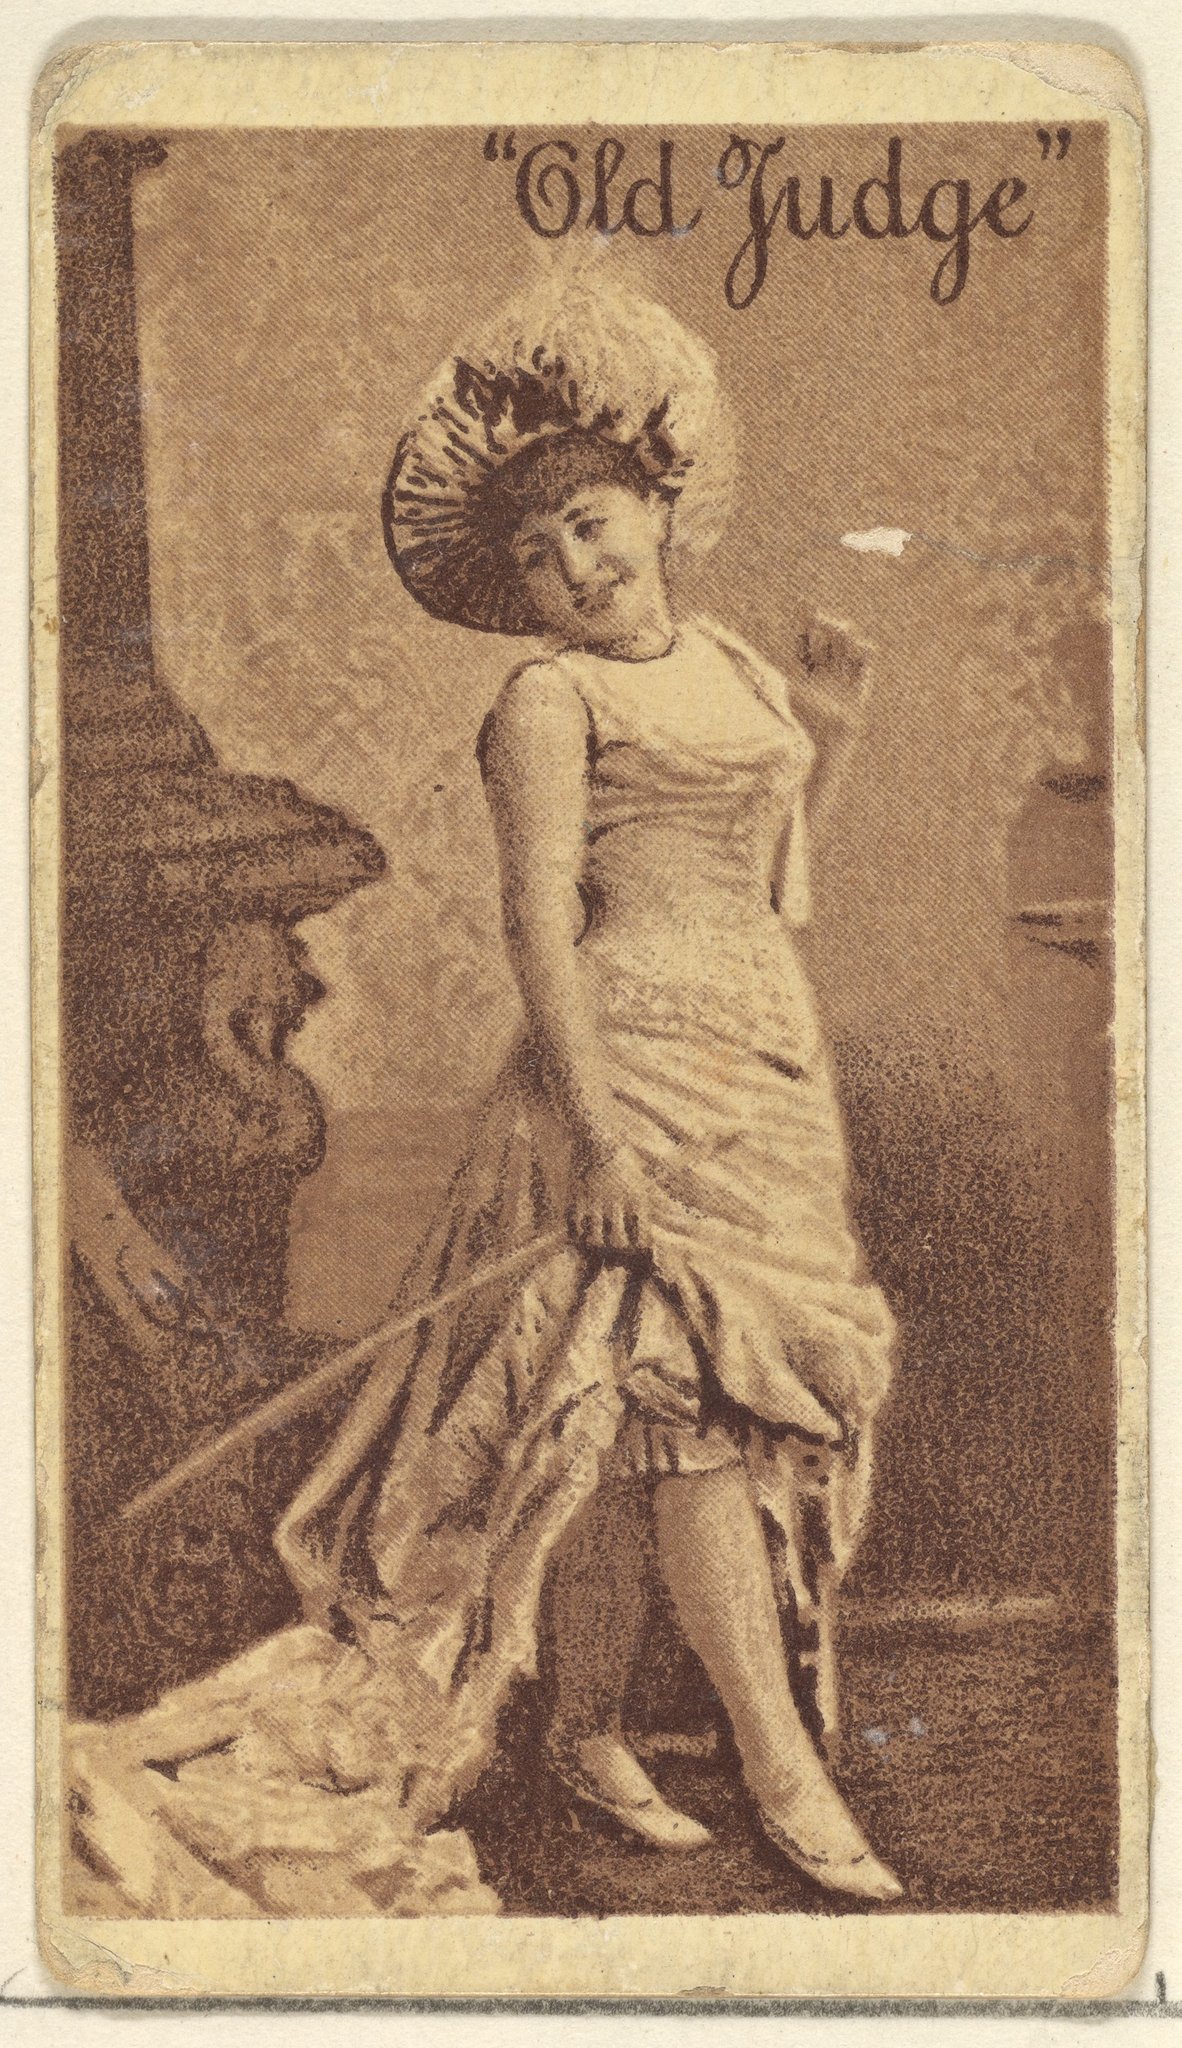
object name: print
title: Actress from the Old Judge series (N167) for Old Judge Cigarettes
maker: goodwin & company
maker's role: publisher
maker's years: 1850-1950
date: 1886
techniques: lithography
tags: portraits,women